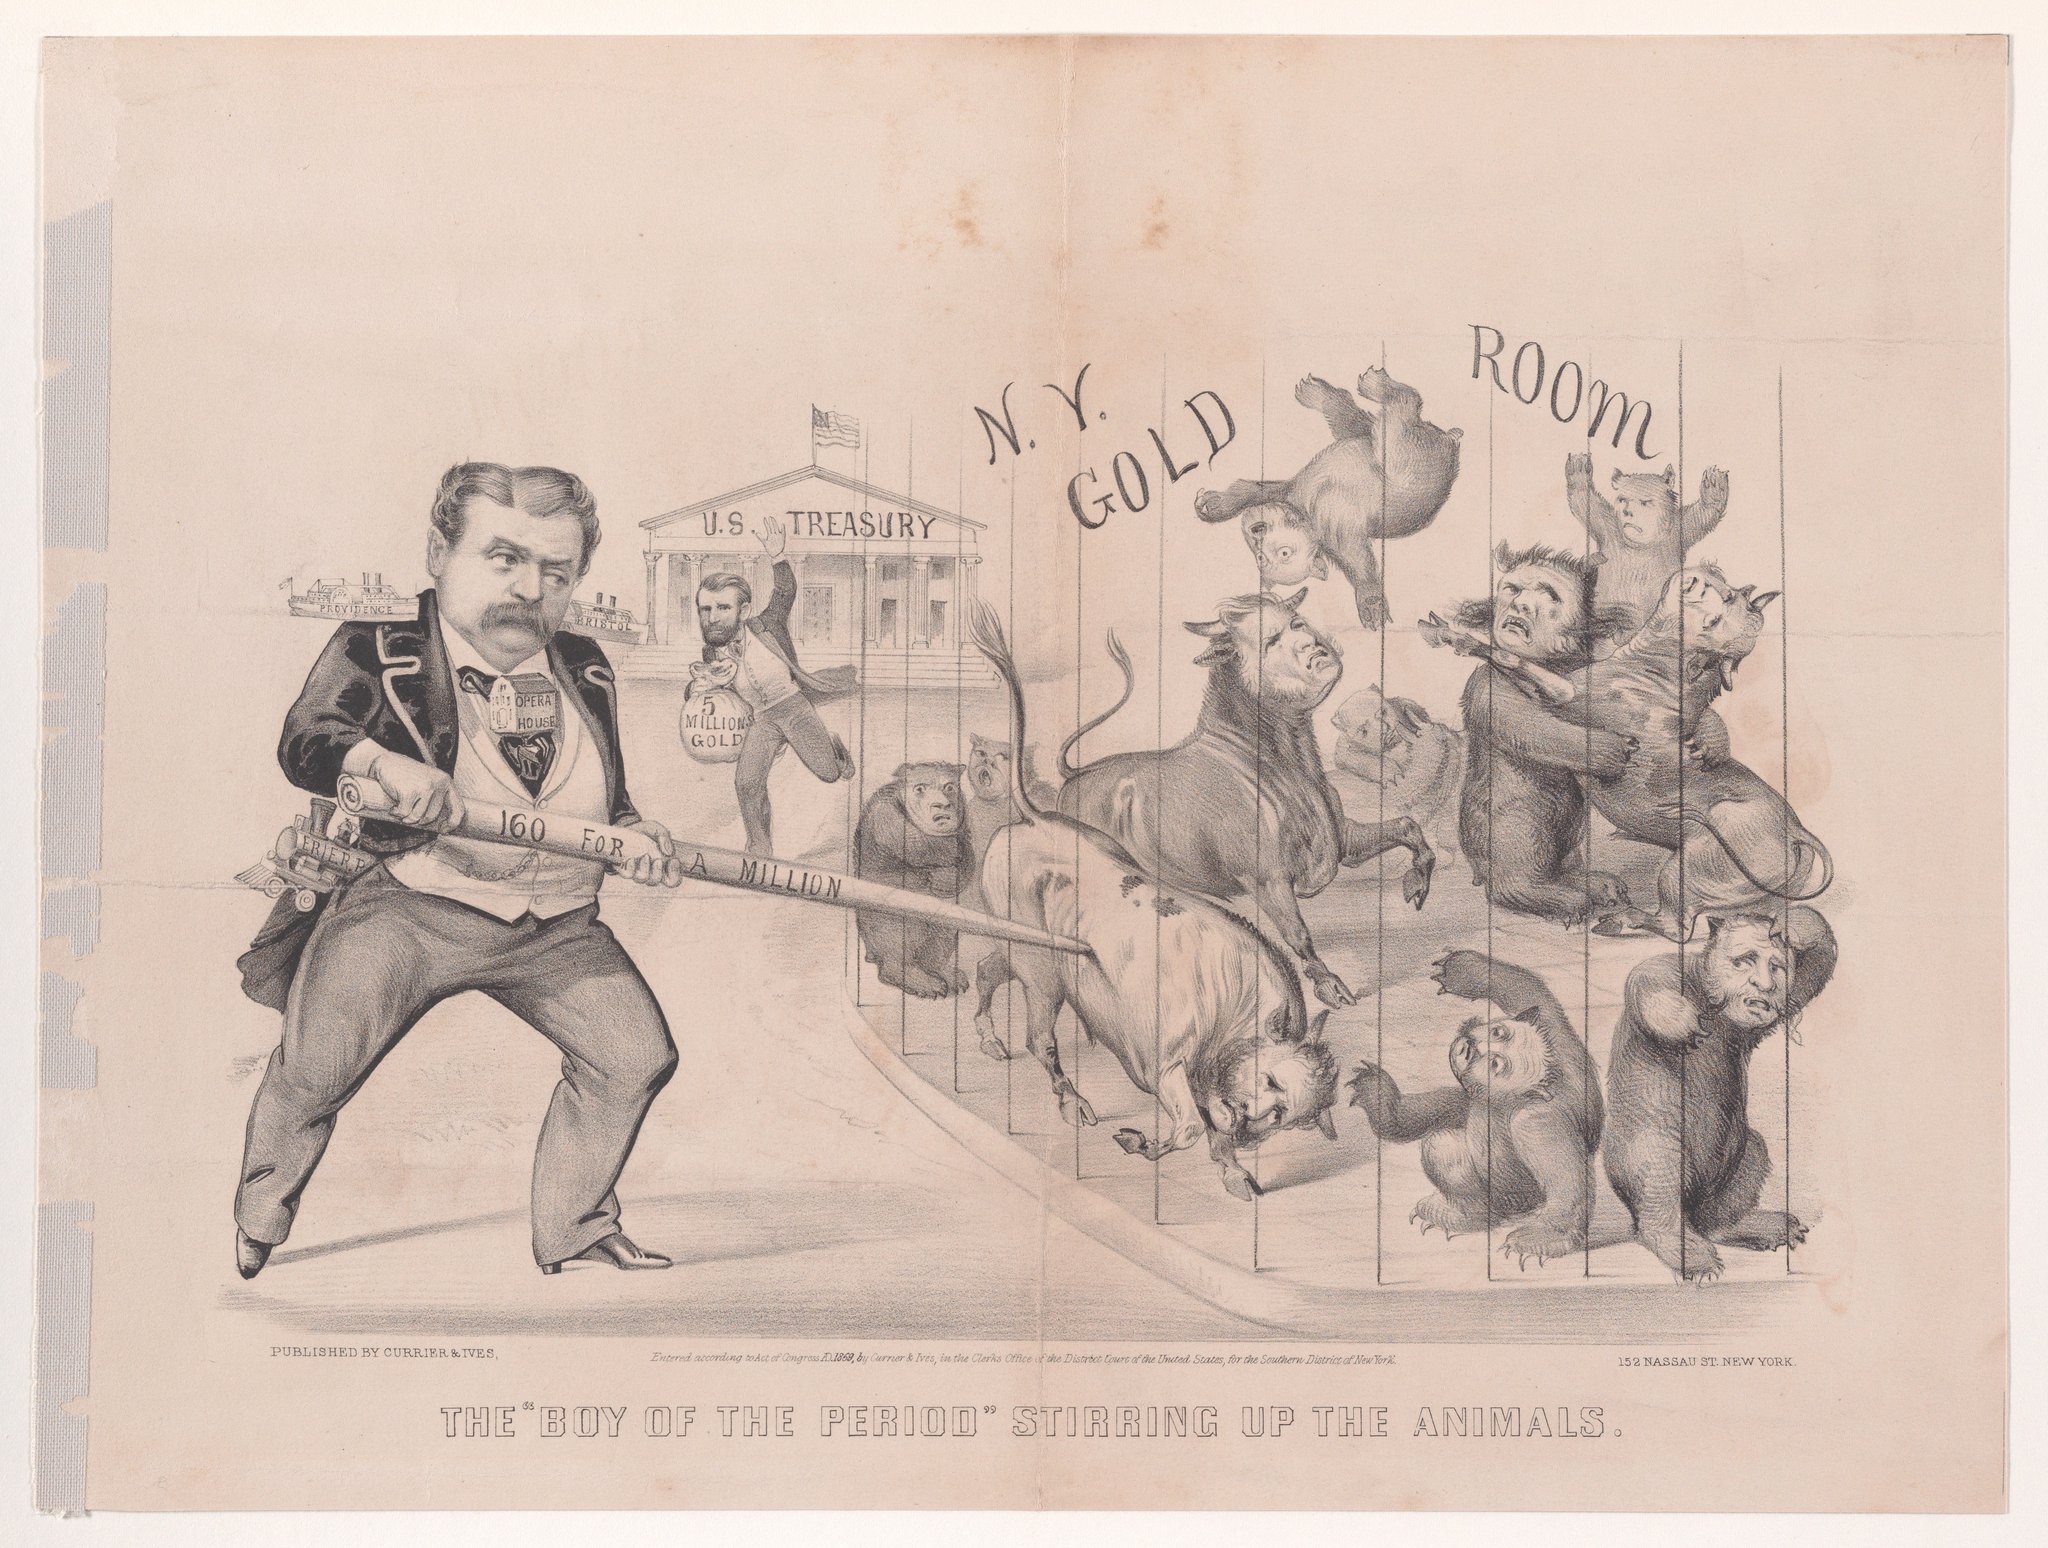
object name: print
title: The "Boy of the Period" Stirring up the Animals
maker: currier & ives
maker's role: publisher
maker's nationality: american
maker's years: 1857-1907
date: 1869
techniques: lithograph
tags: animals,satire,men,caricature,politics